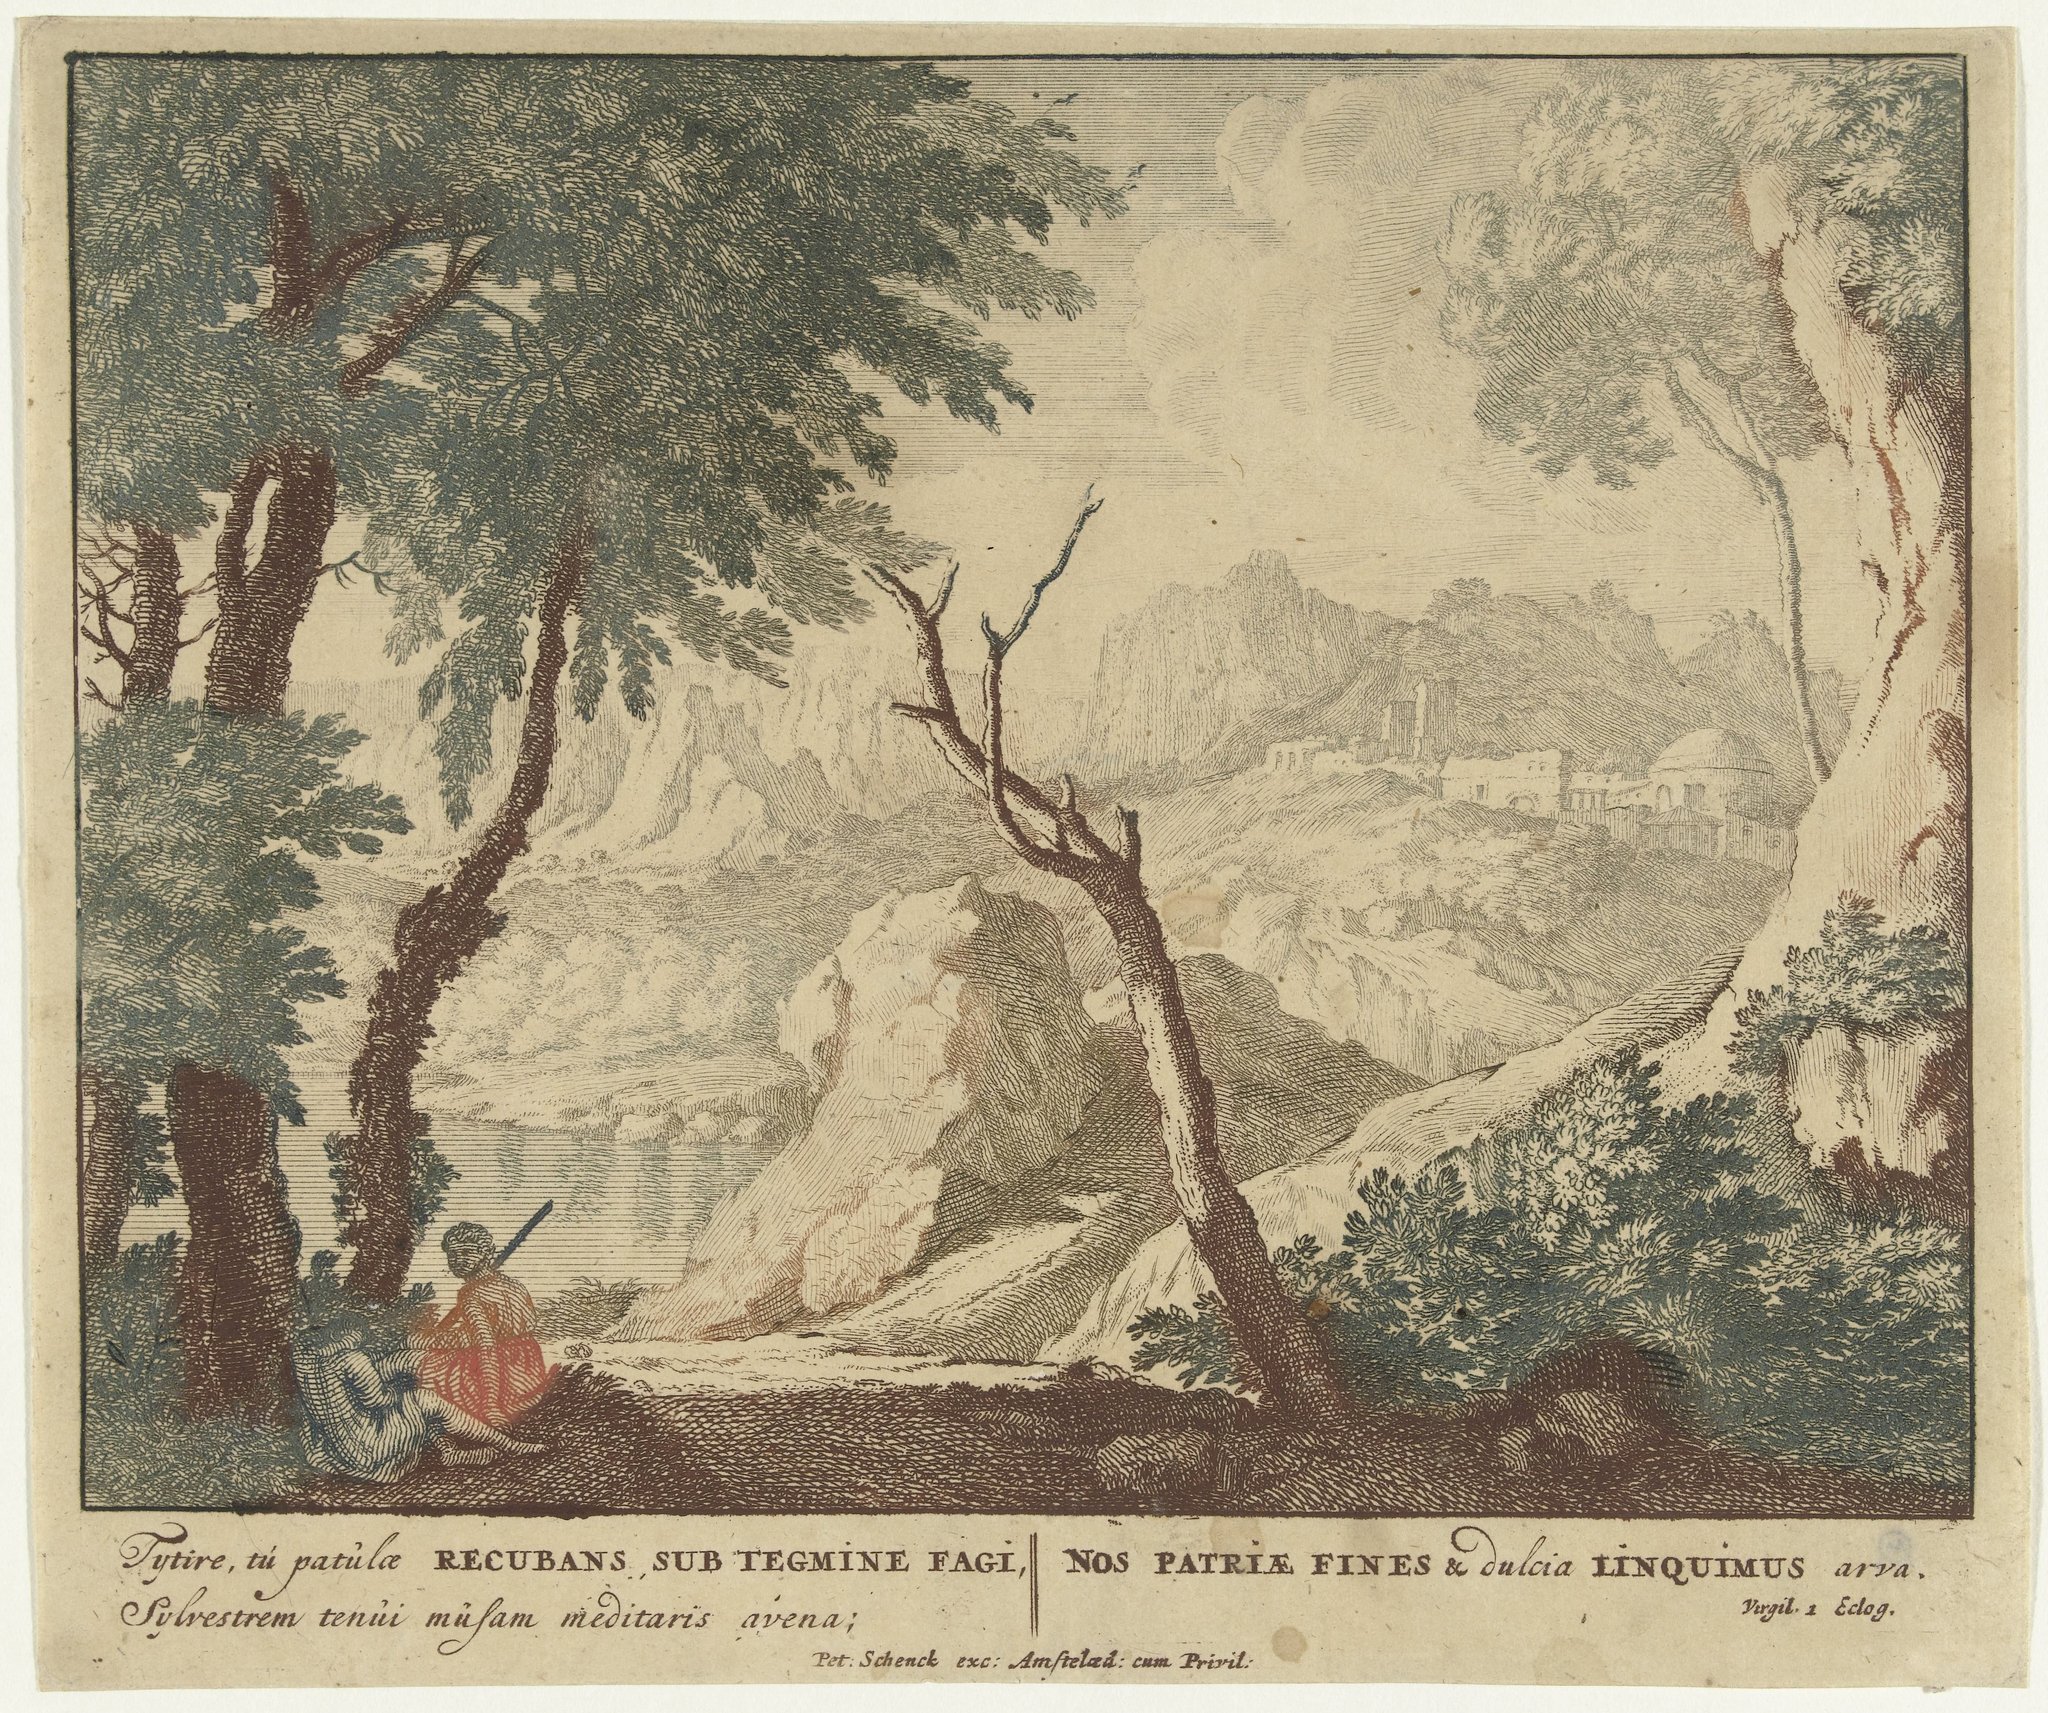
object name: print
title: Herder en herderin rusten uit bij een boom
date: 1666-1706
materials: paper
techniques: etching, lithography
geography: amsterdam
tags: pastorals, arcadian scenes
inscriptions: collector's mark: Lugt 2760, collector's mark: Lugt 2228, collector's mark: Lugt 1904, collector's mark: Lugt 2749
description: Illustratie voor Ecloga 1 van Virgilius. Een herder en een herderin rusten uit in de schaduw van een boom. Vanuit hun plek hebben ze mooi uitzicht over een dal met een meer en een stad die tussen de rotsen verborgen ligt.